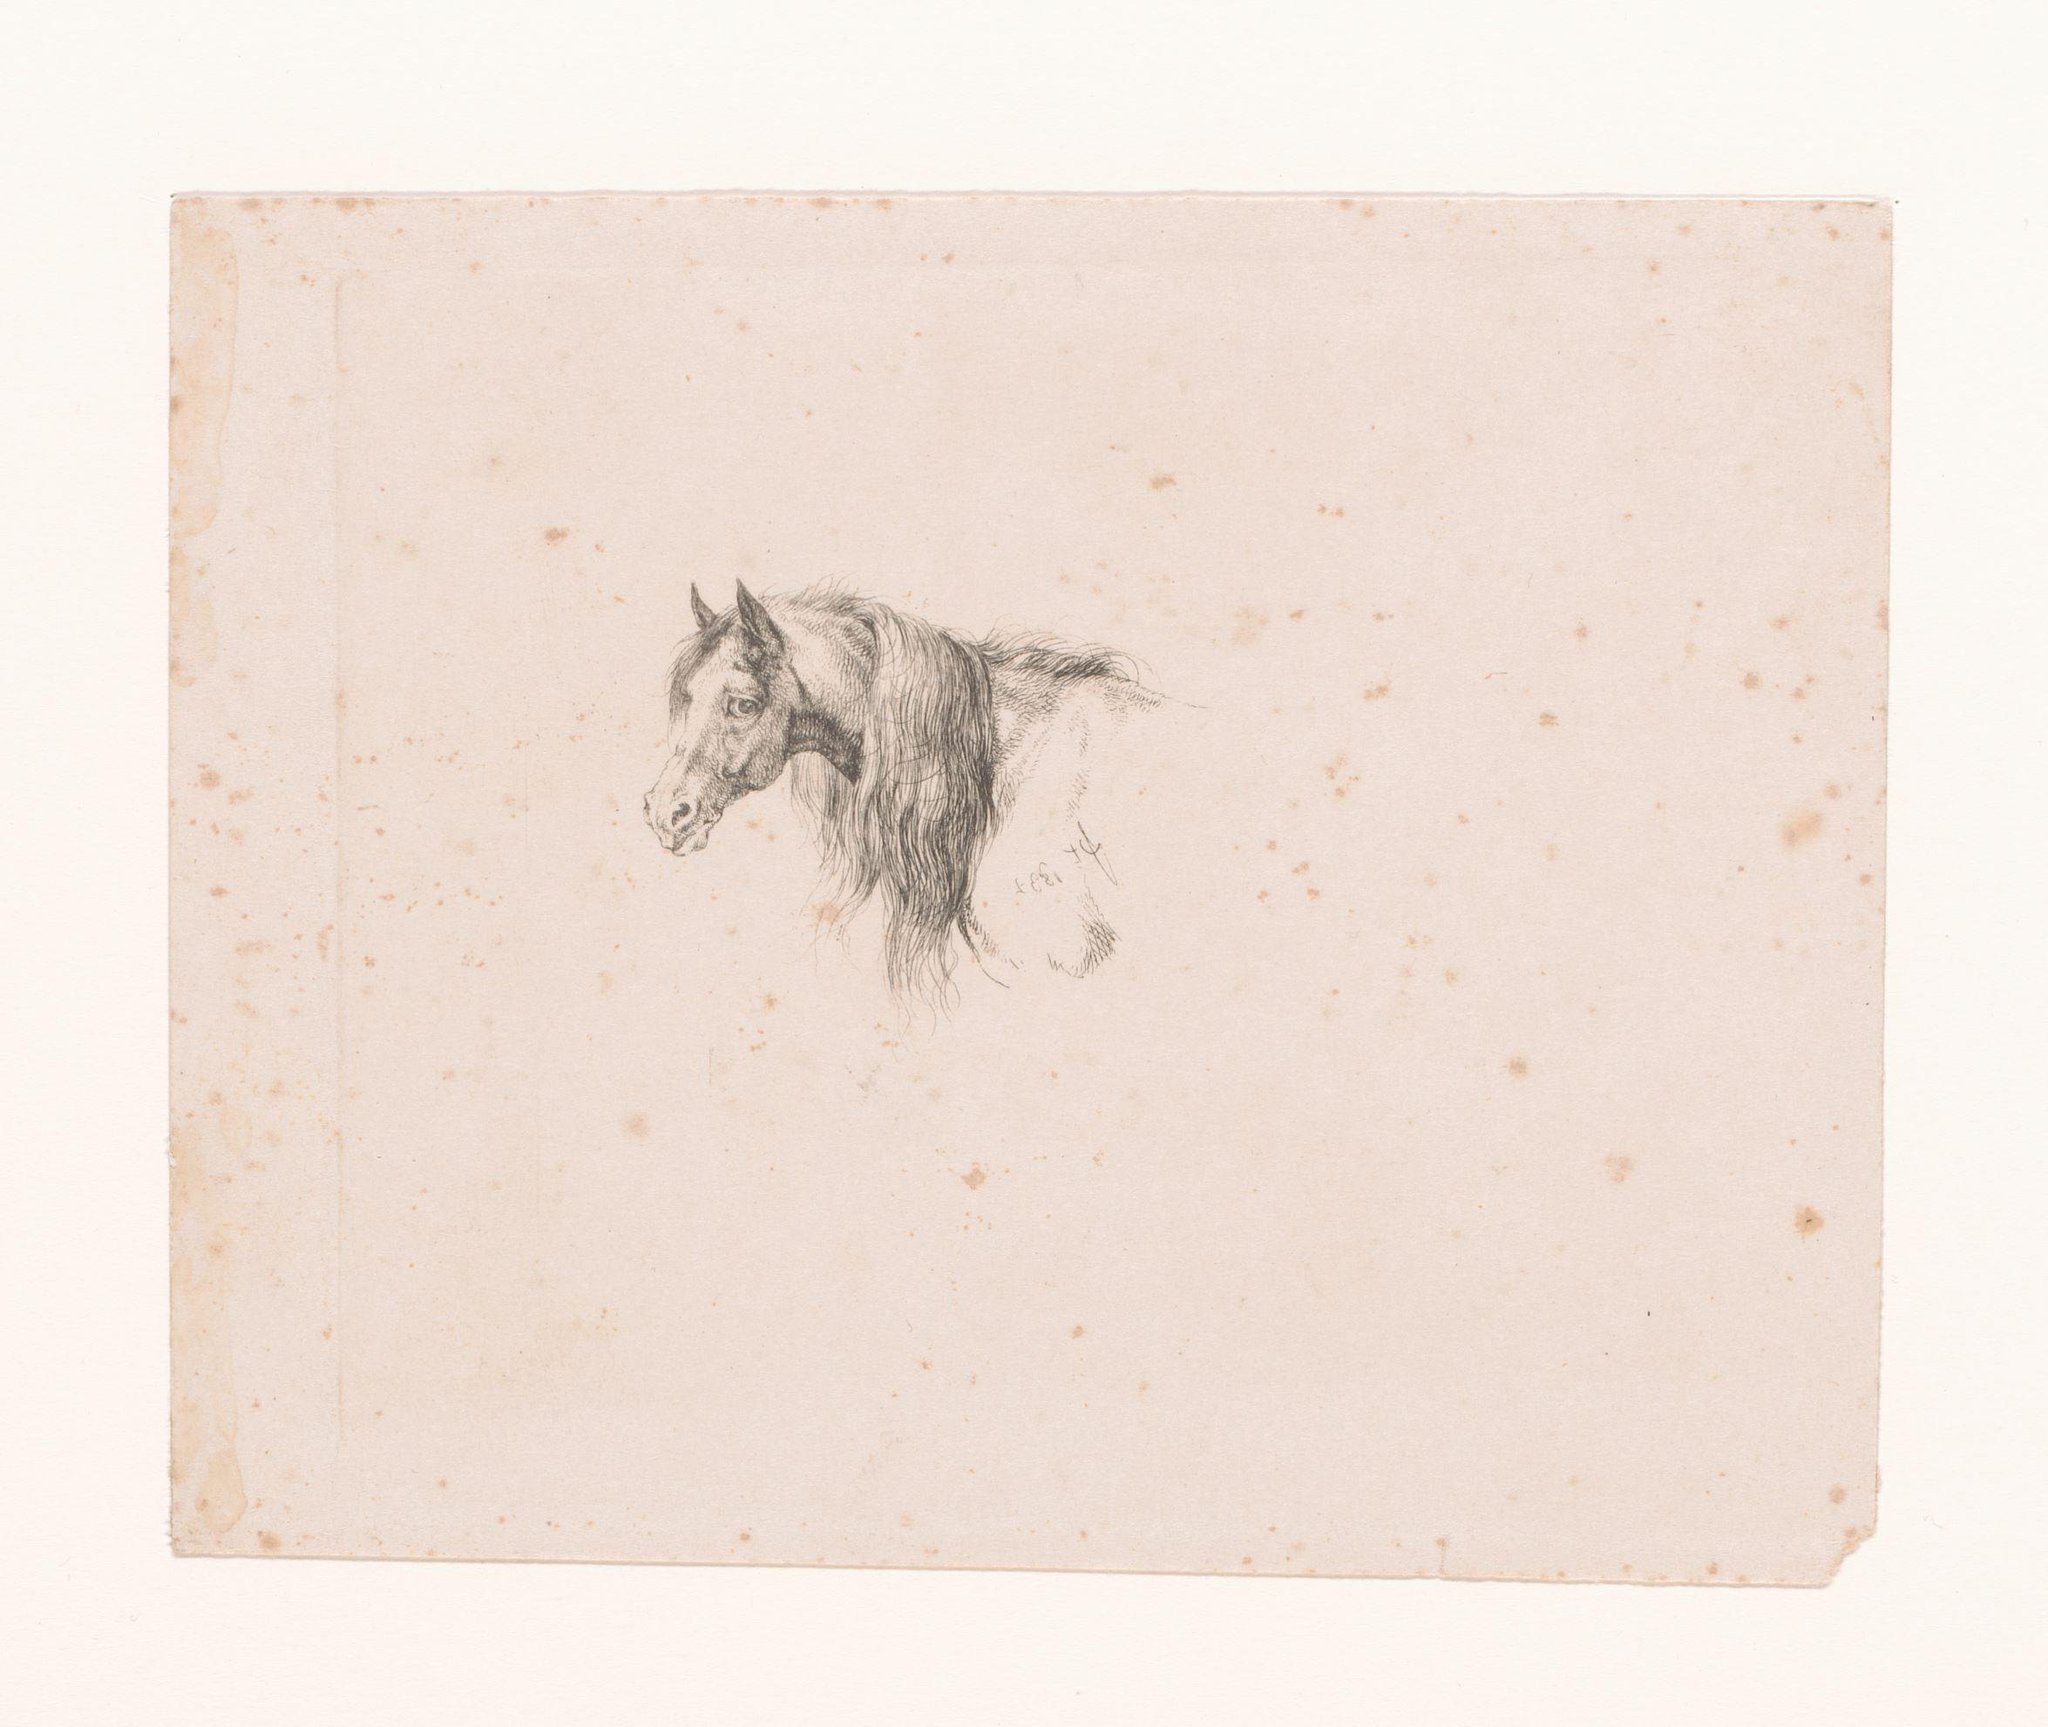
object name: print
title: Paardenhoofd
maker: eugène verboeckhoven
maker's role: draughtsman, painter, print maker, printer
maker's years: 1798-1881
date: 1832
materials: paper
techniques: etching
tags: horse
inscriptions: date